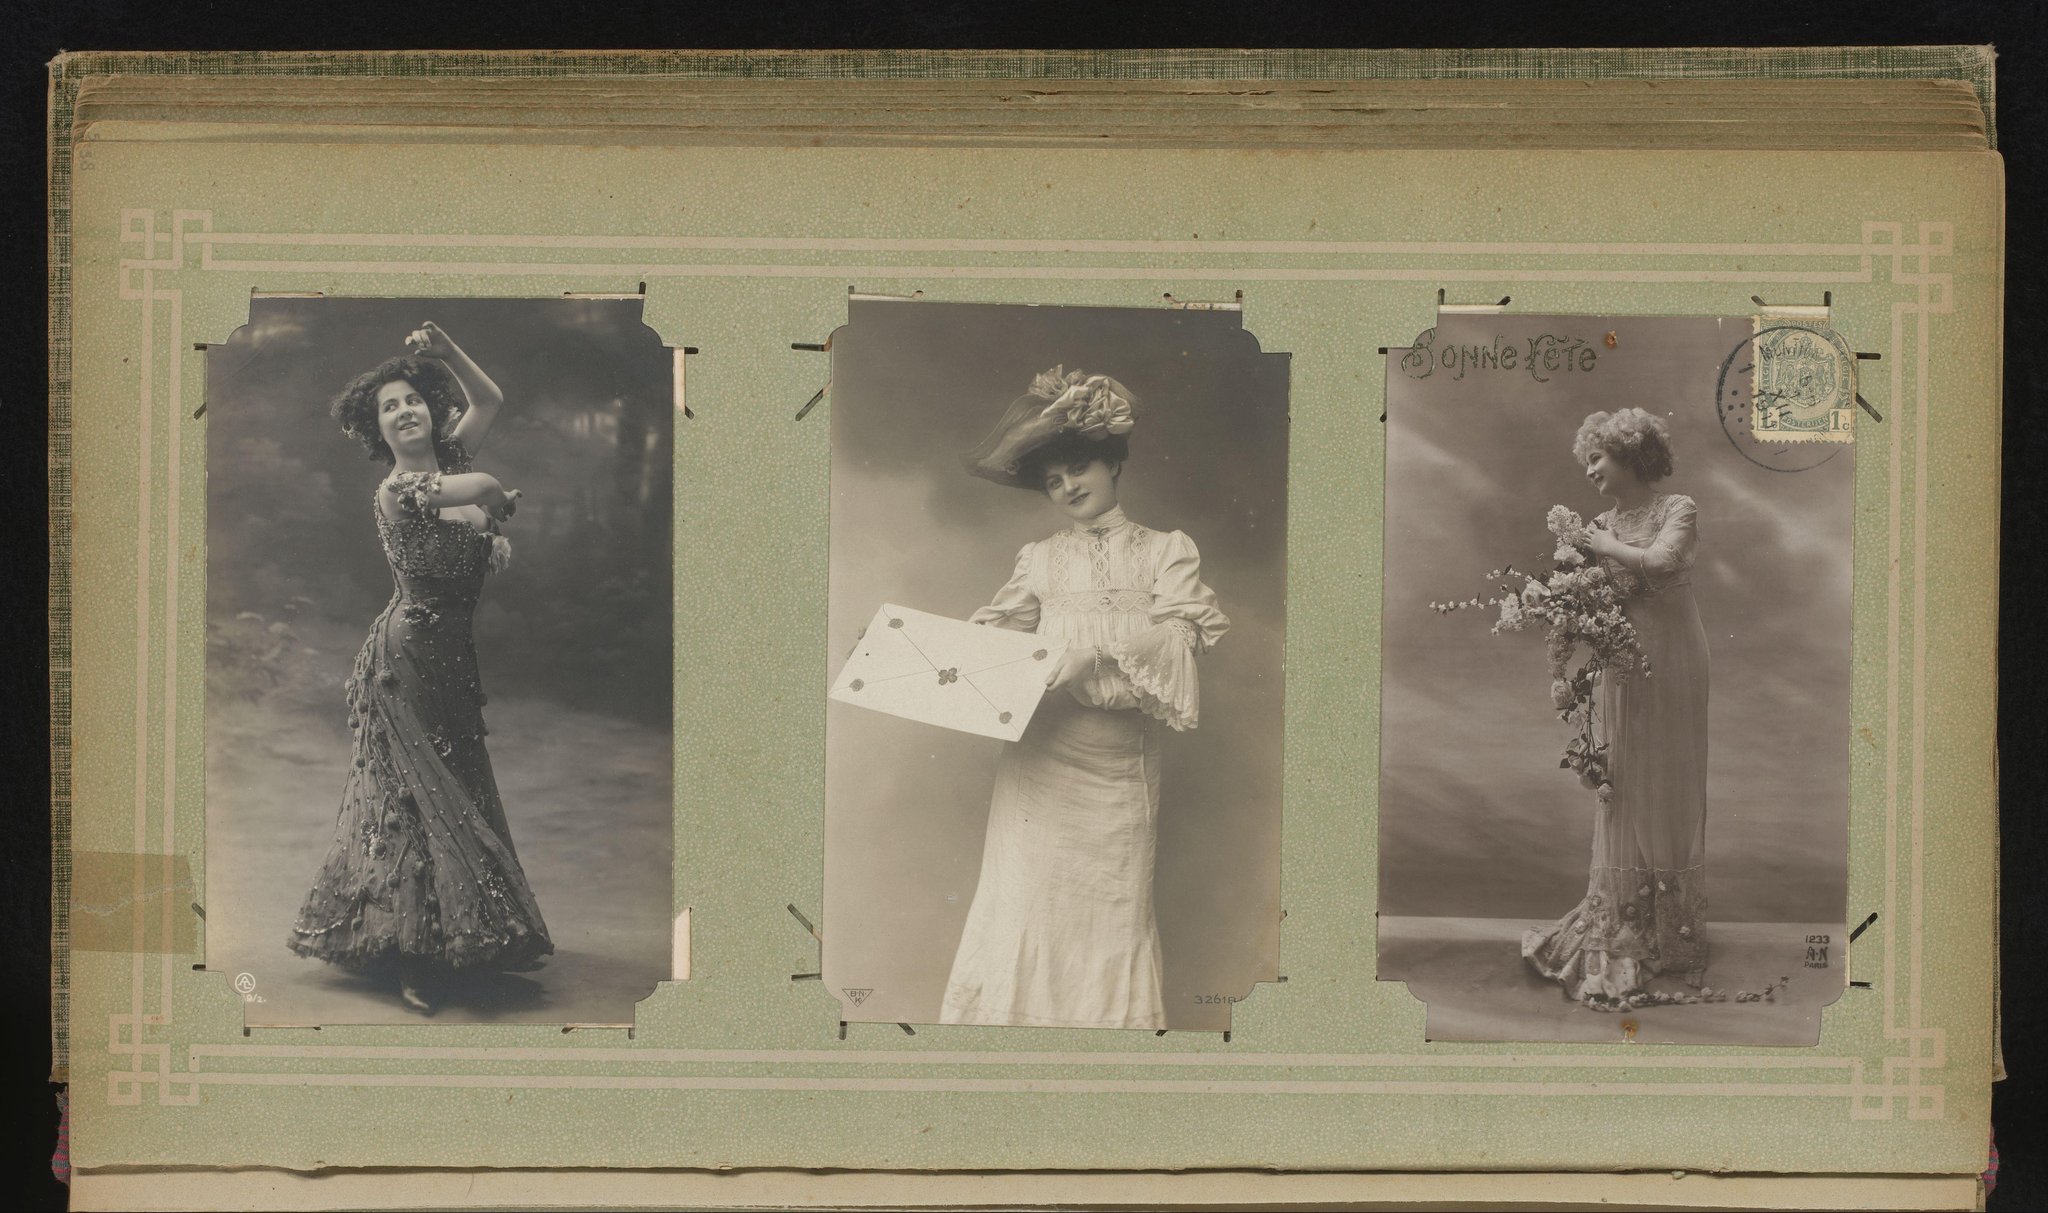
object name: ansichtkaart, prentbriefkaart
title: Drie portretten van vrouwen, onder wie een vrouw met een grote envelop in de hand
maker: Anonymous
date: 1900-1930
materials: cardboard, photographic support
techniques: gelatin silver print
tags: historical persons - bb - woman, head-gear: hat, letter, envelope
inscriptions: monogram: ‘A/ [T]’, monogram: ‘B N/ K’, monogram: ‘A N/ PARIS’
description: Deze foto's maken deel uit van een album.